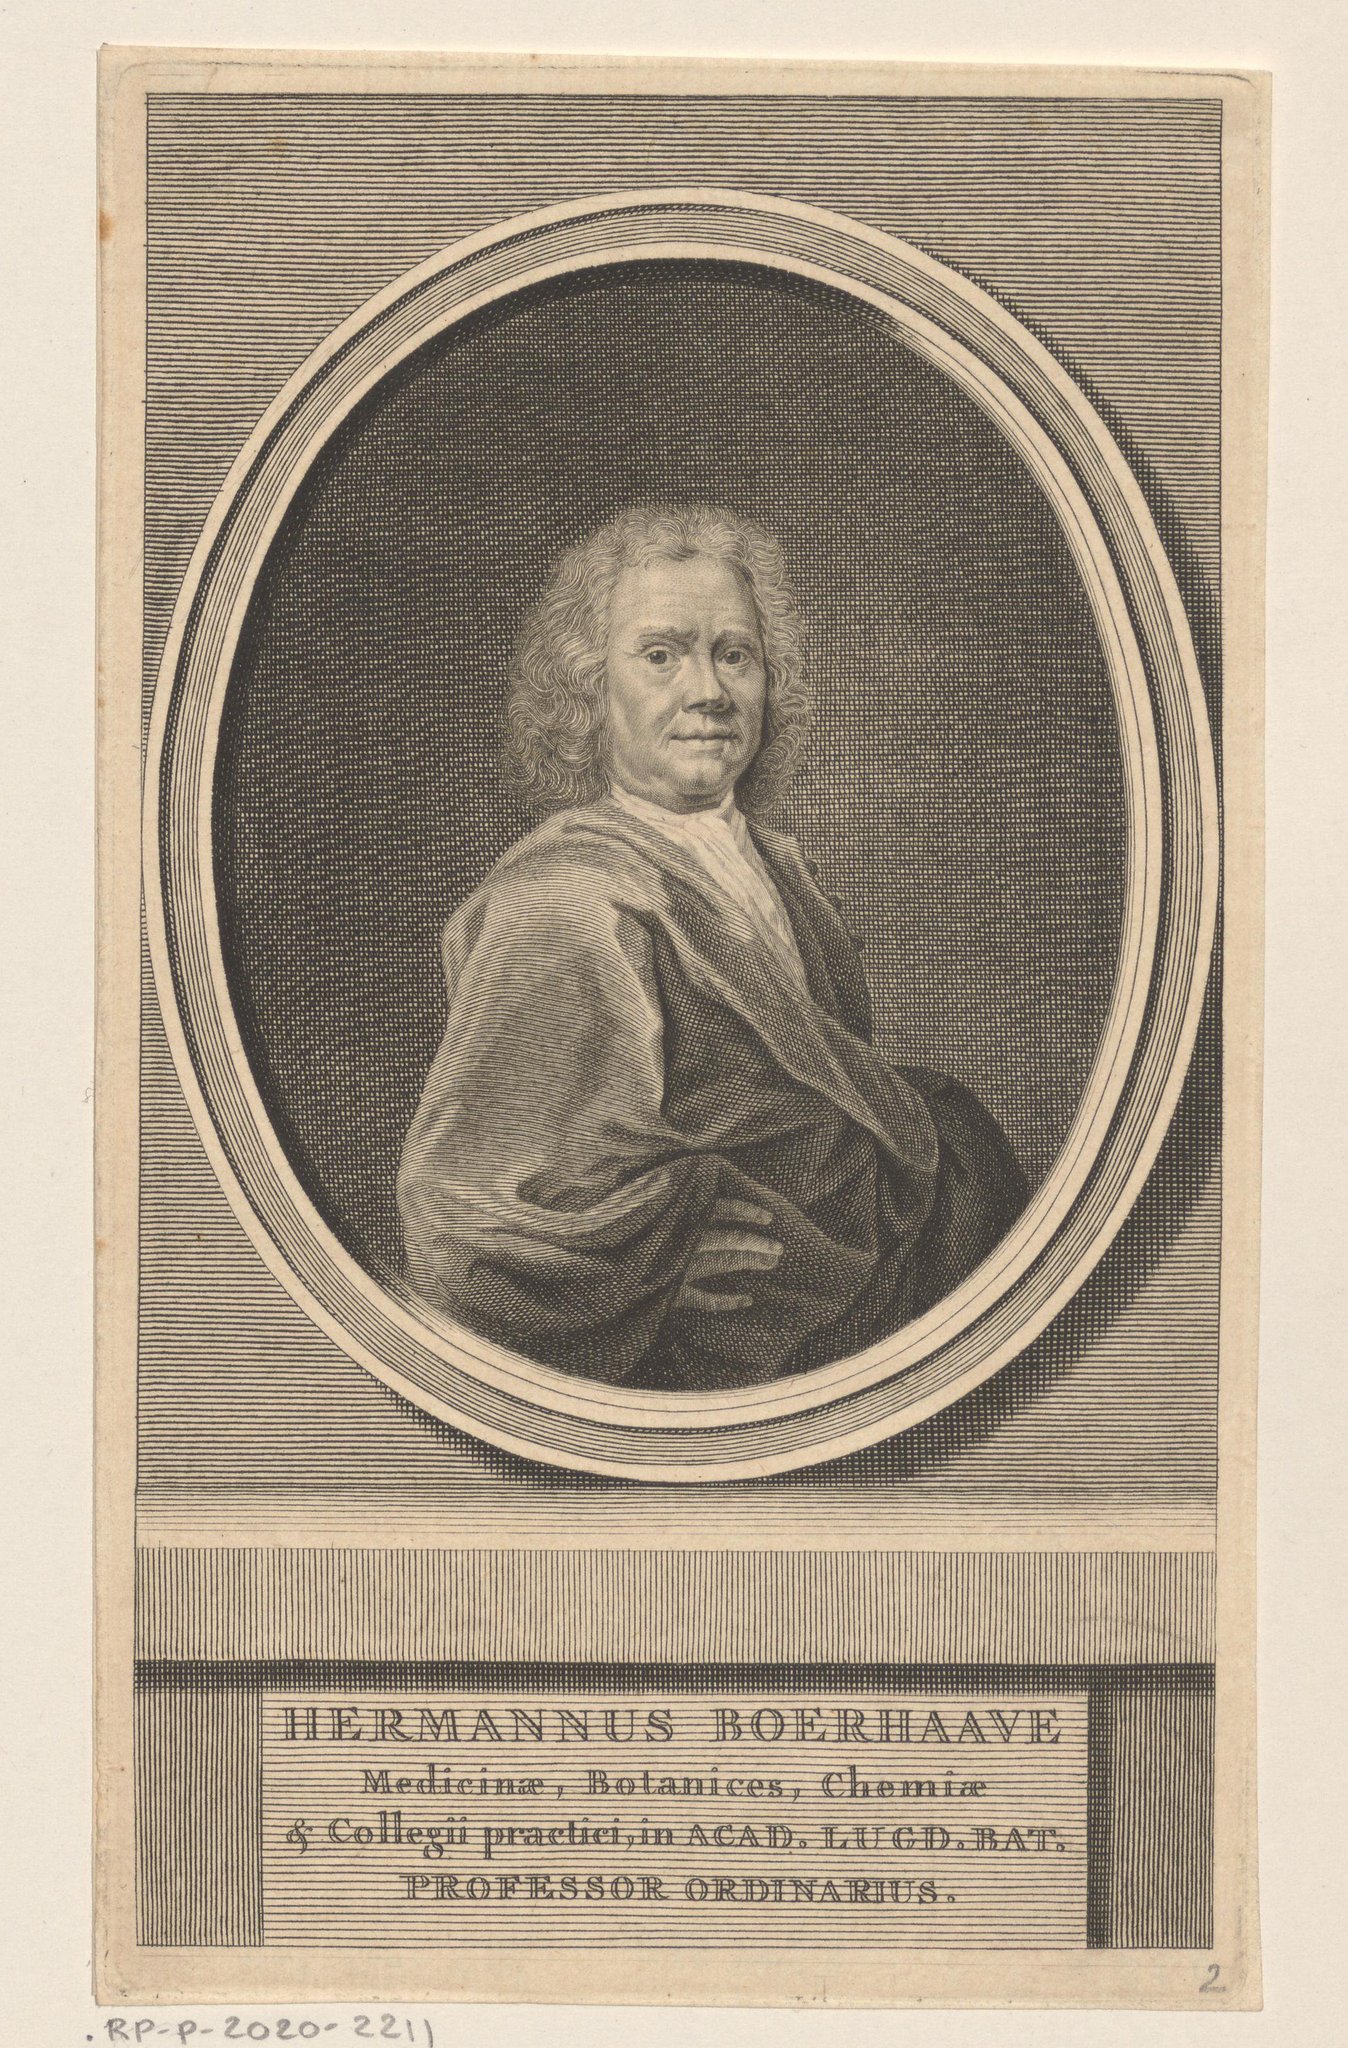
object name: print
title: Portret van Hermanus Boerhaave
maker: Anonymous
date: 1750-1799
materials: paper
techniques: engraving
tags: hermanus boerhaave, historical persons, physician, doctor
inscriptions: collector's mark: Lugt 240